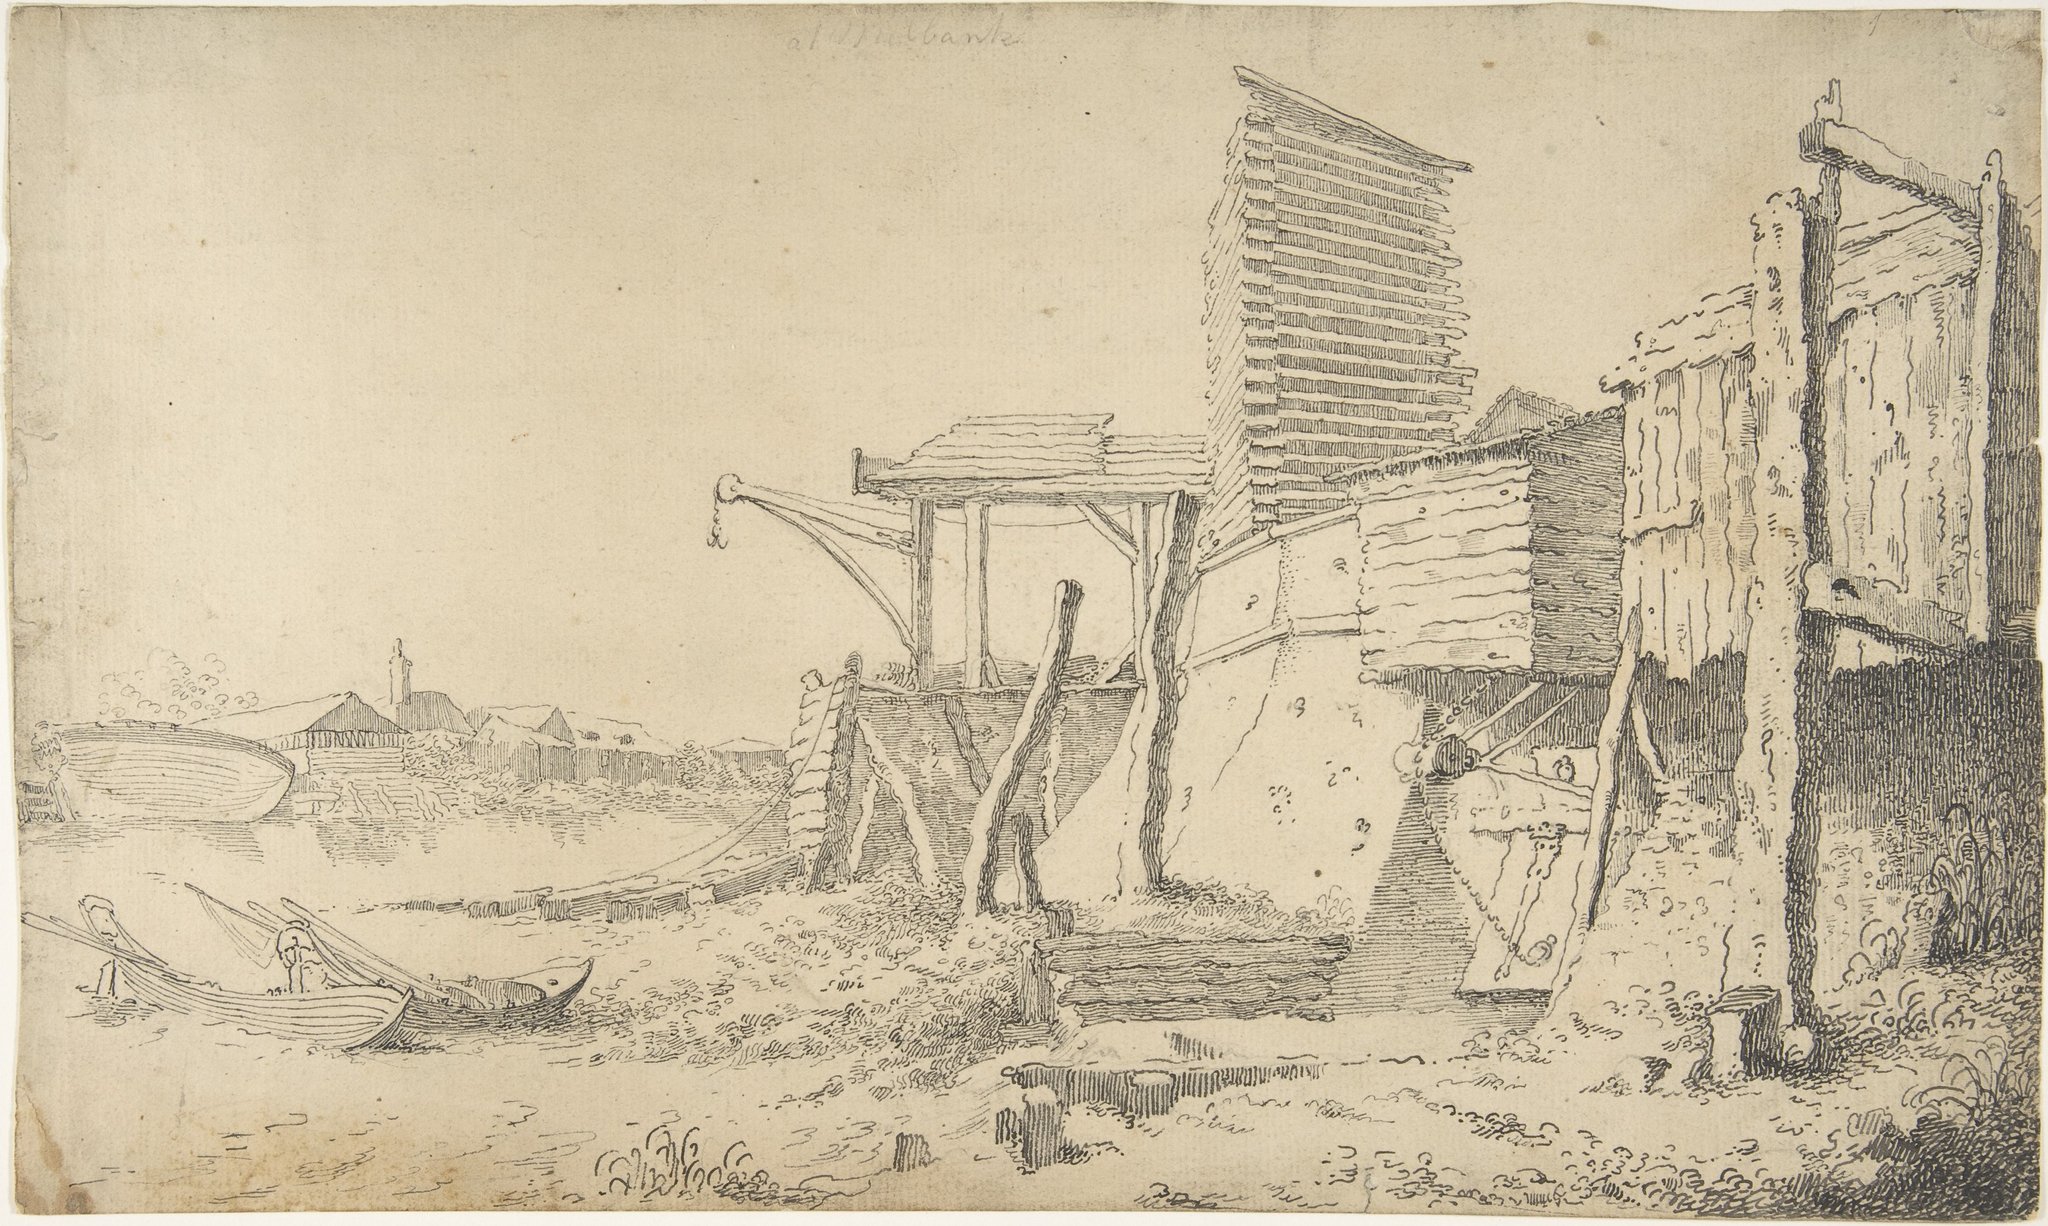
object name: drawing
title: Building On a Riverbank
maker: anonymous, british, late 18th century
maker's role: artist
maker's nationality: british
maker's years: 1750-1800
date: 1760-1800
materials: ink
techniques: pen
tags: buildings,rivers,boats